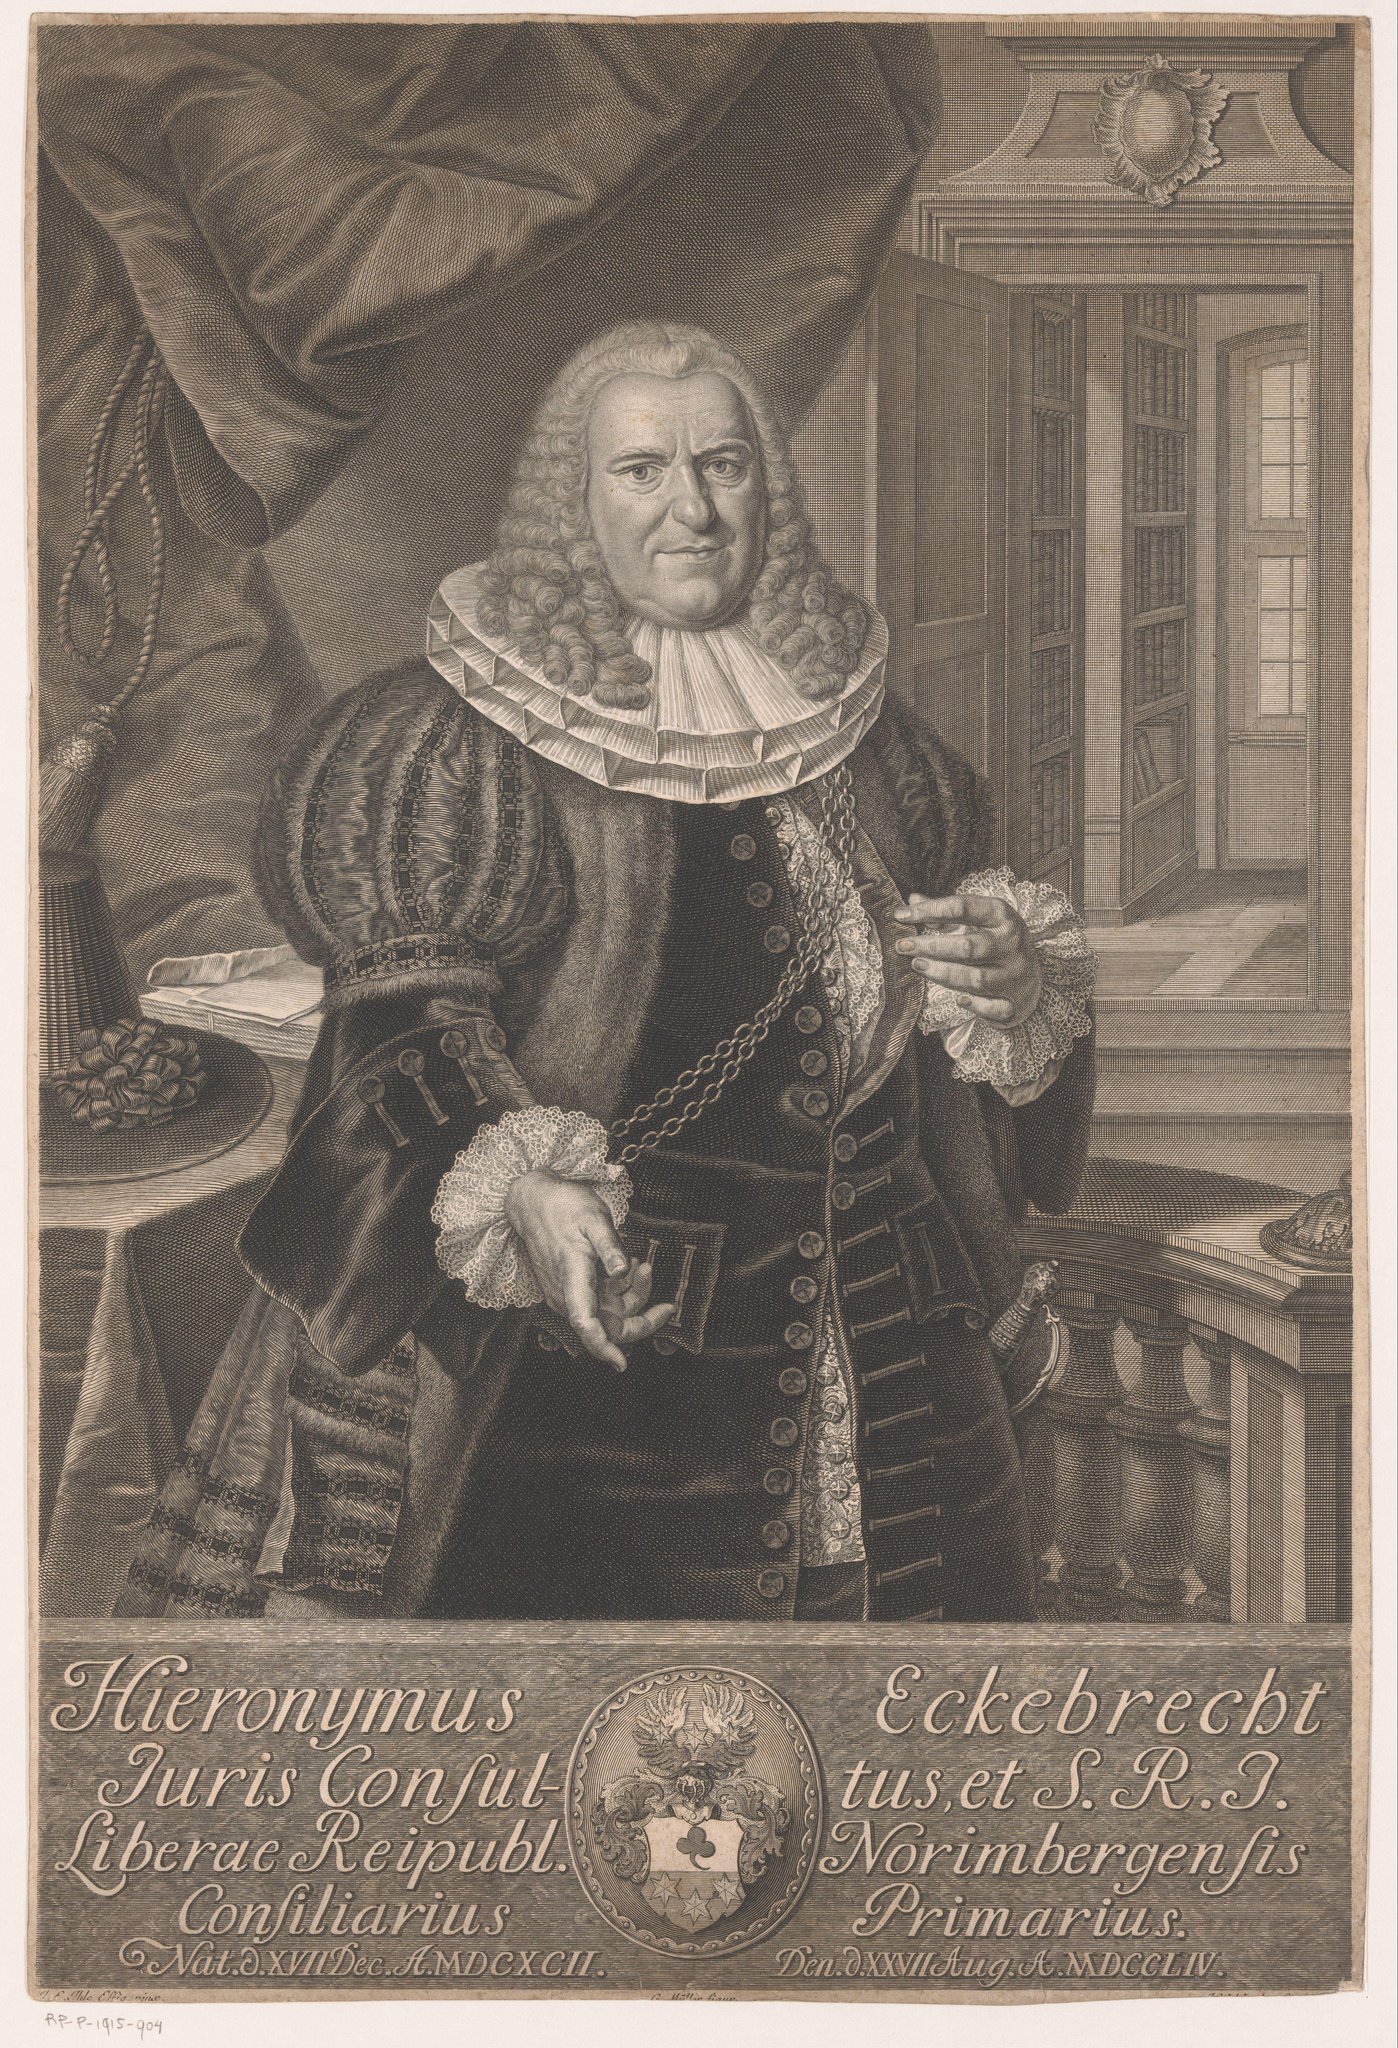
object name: print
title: Portret van Hieronymus Eckebrecht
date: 1755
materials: paper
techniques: engraving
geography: nuremberg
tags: historical persons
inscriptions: collector's mark: Lugt 2228